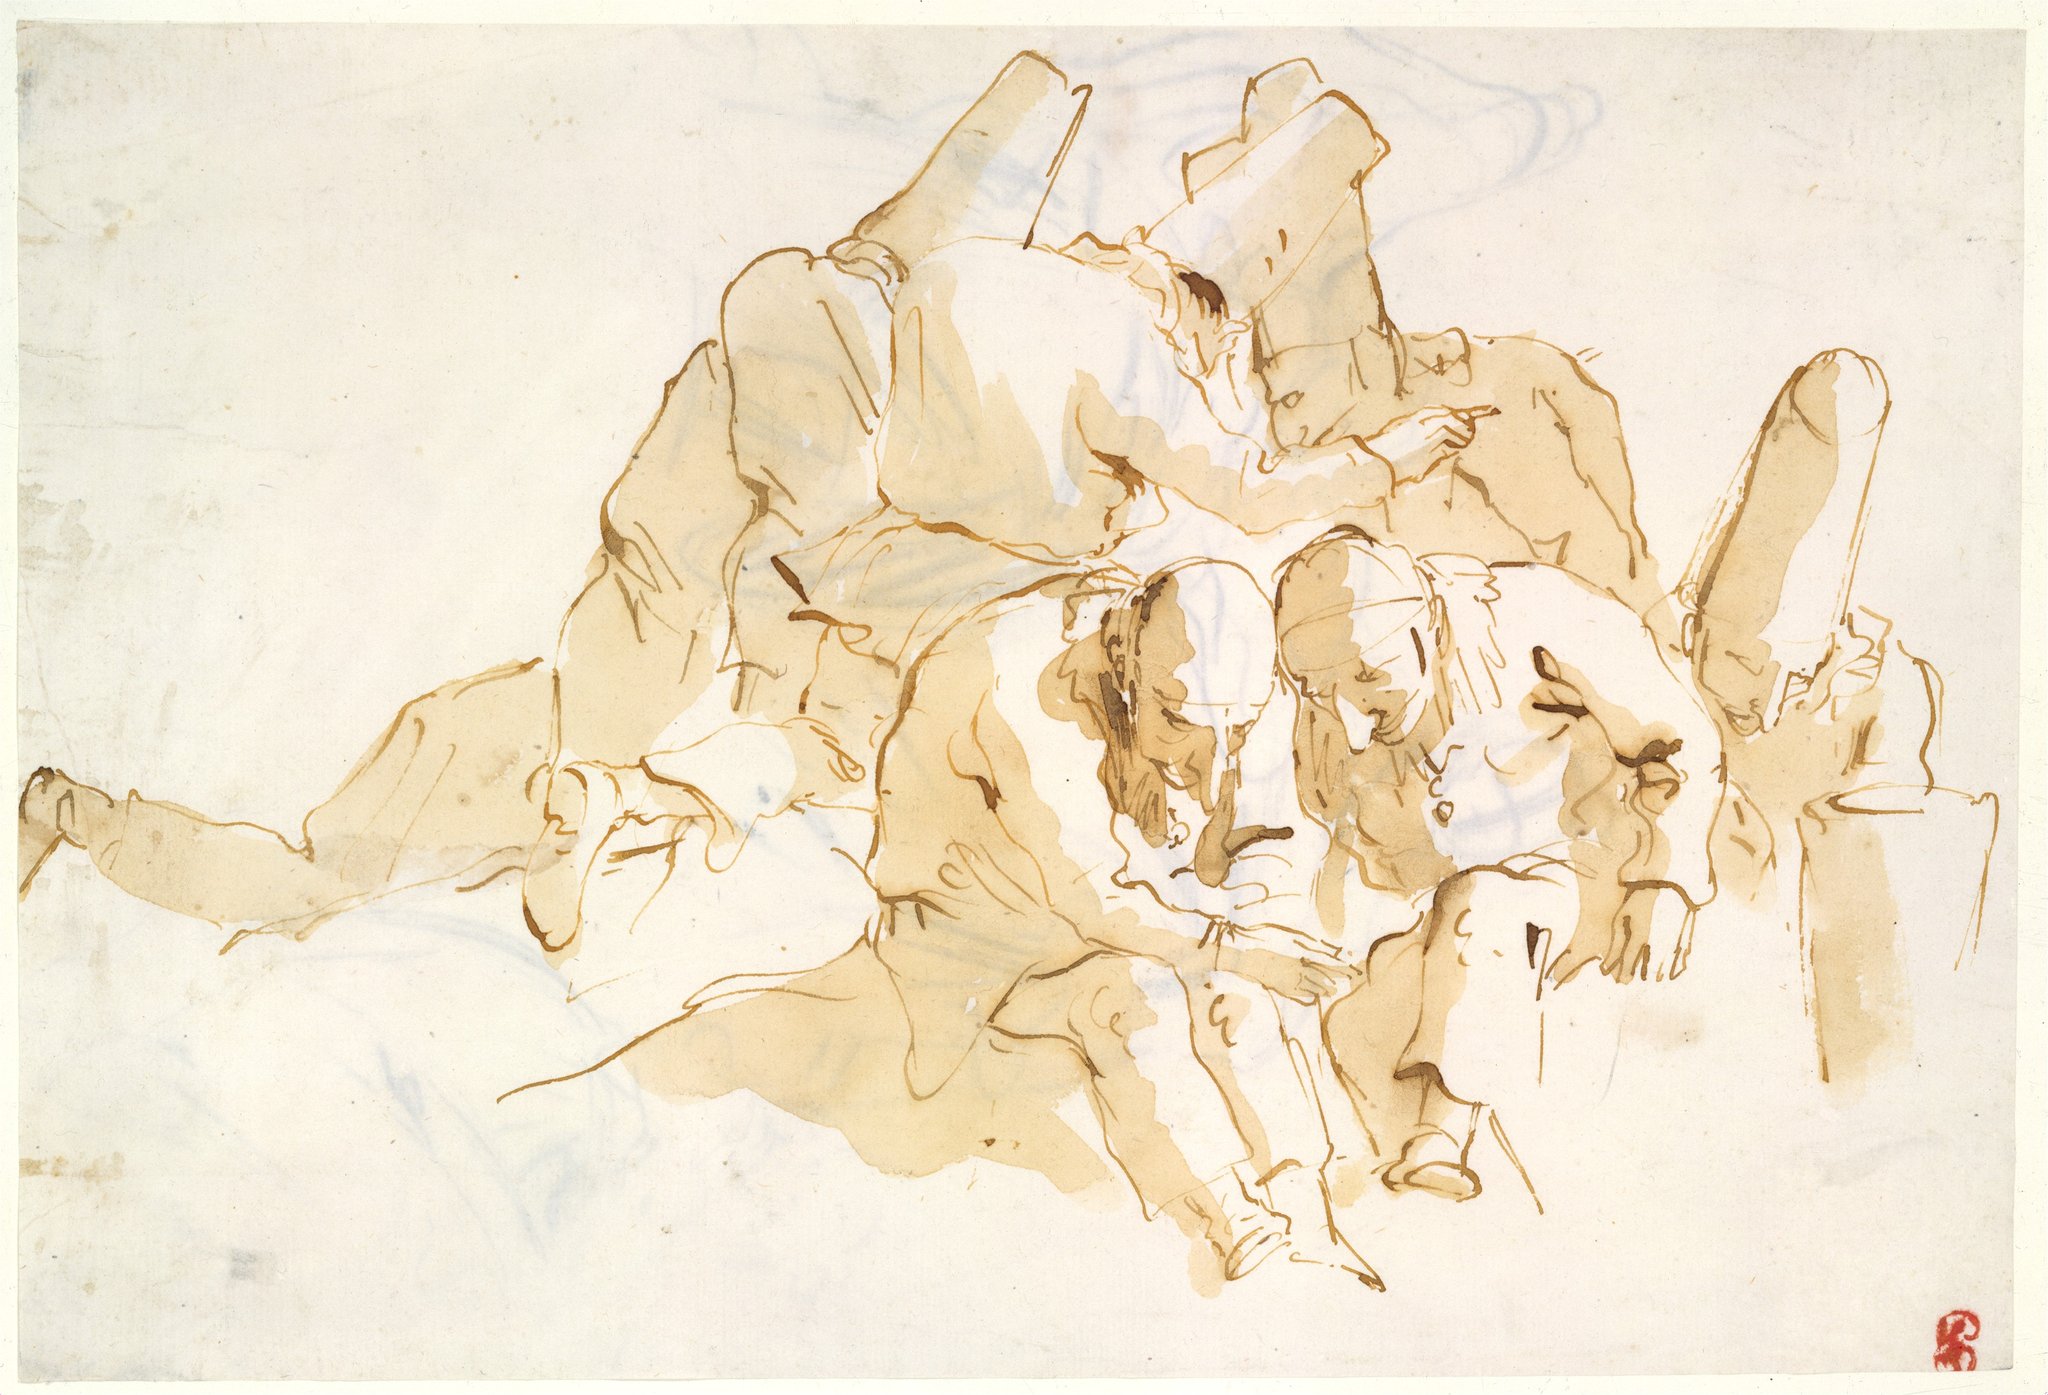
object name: drawing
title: A Group of Punchinelli Seated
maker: giovanni battista tiepolo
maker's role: artist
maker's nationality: italian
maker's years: 1696-1770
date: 1760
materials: chalk, ink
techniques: pen, wash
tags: men